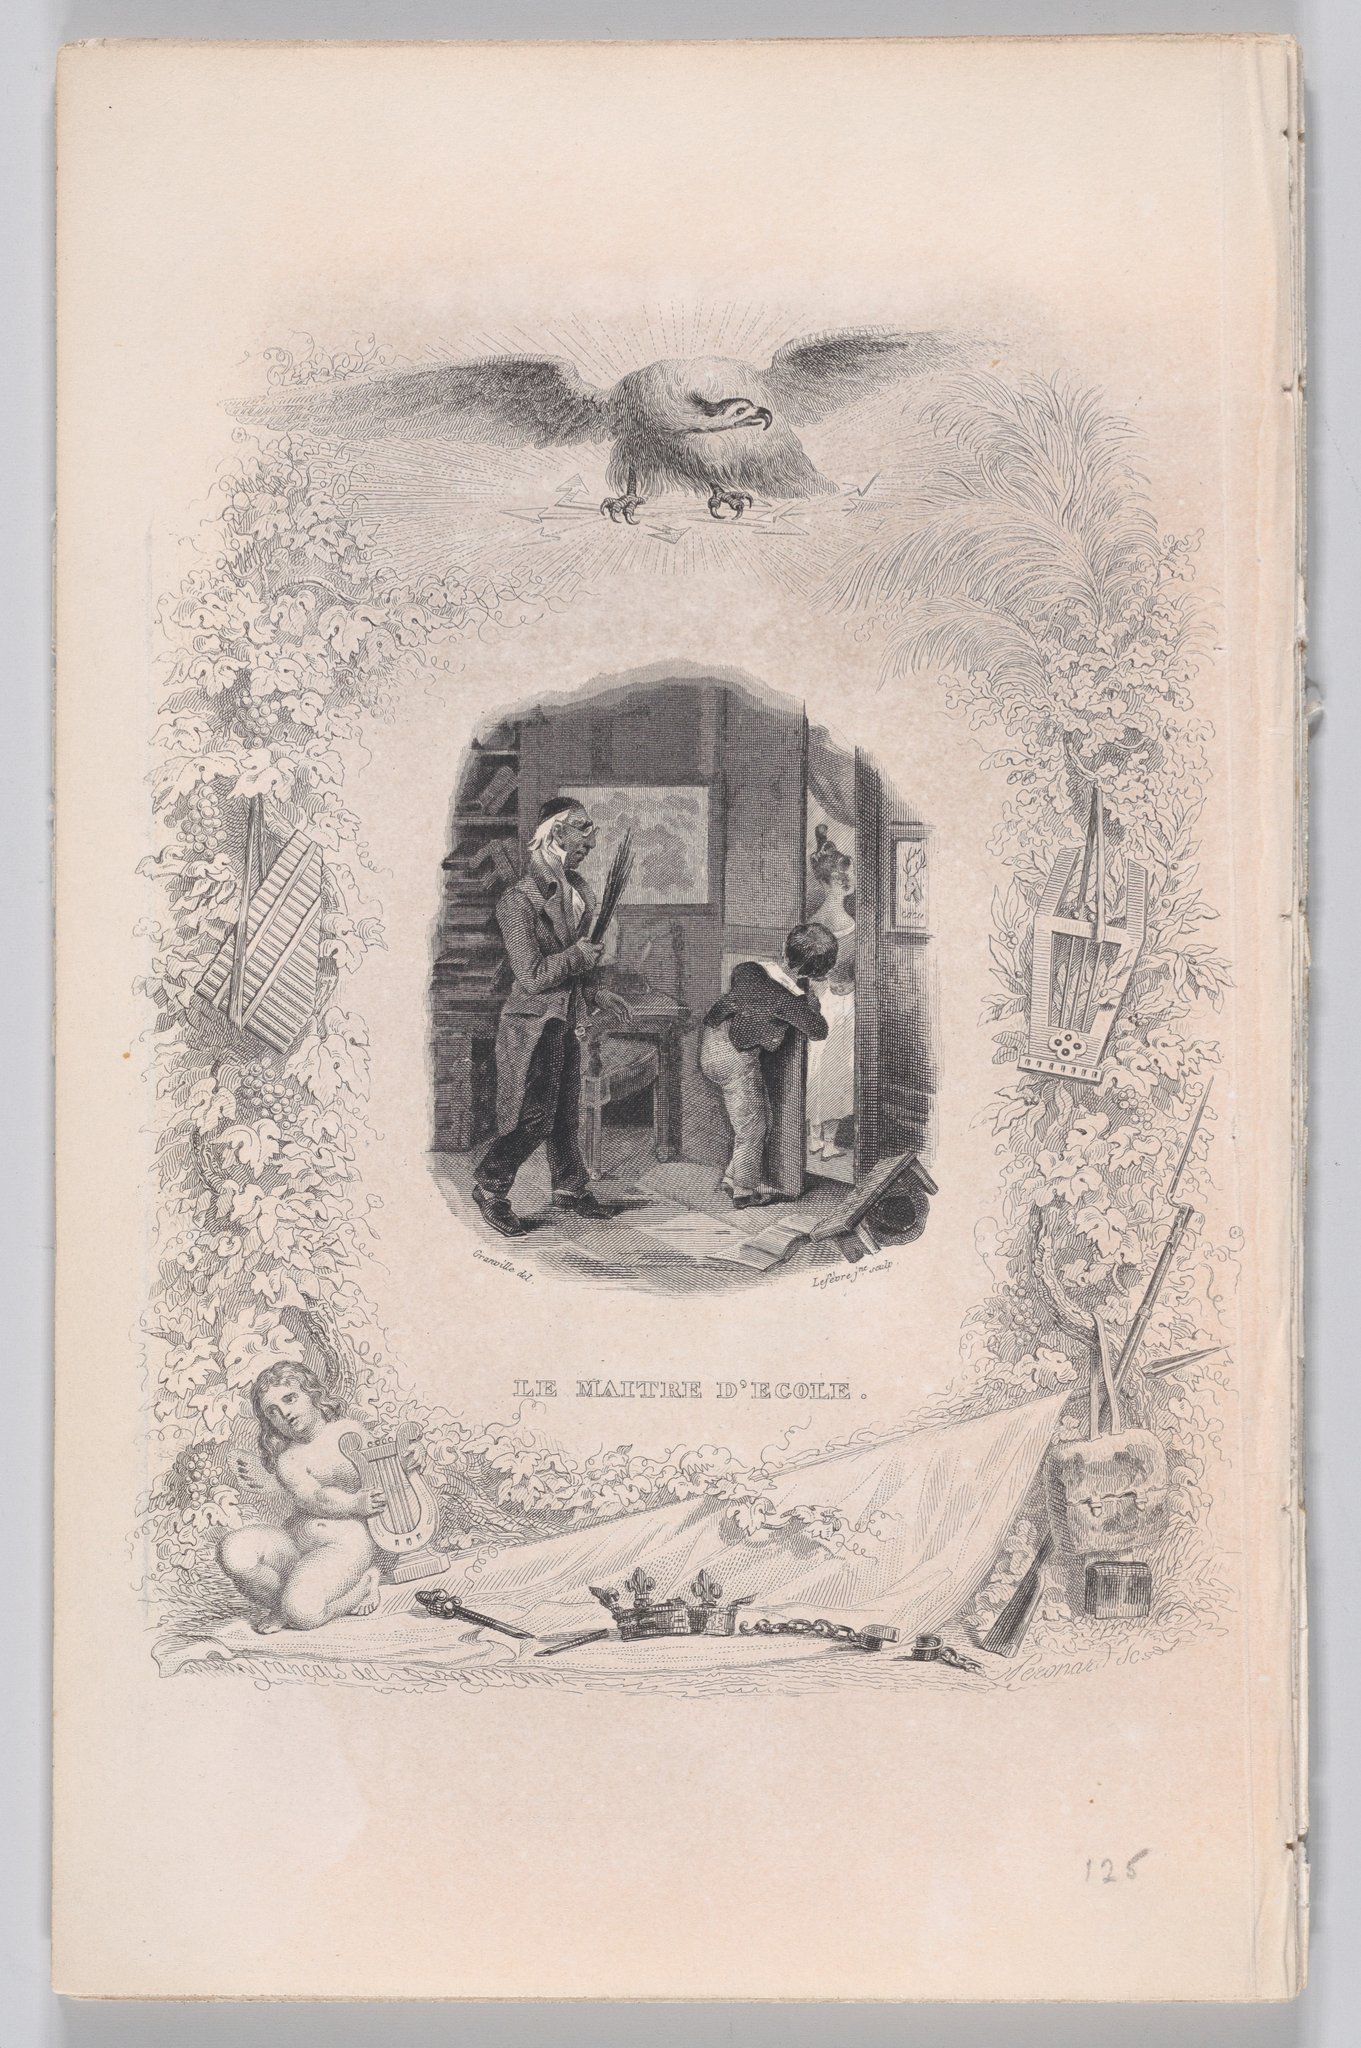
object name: print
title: The Schoolmaster, from "The Complete Works of Béranger"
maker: j. j. grandville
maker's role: designer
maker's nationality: french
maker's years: 1803-1847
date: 1829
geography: paris